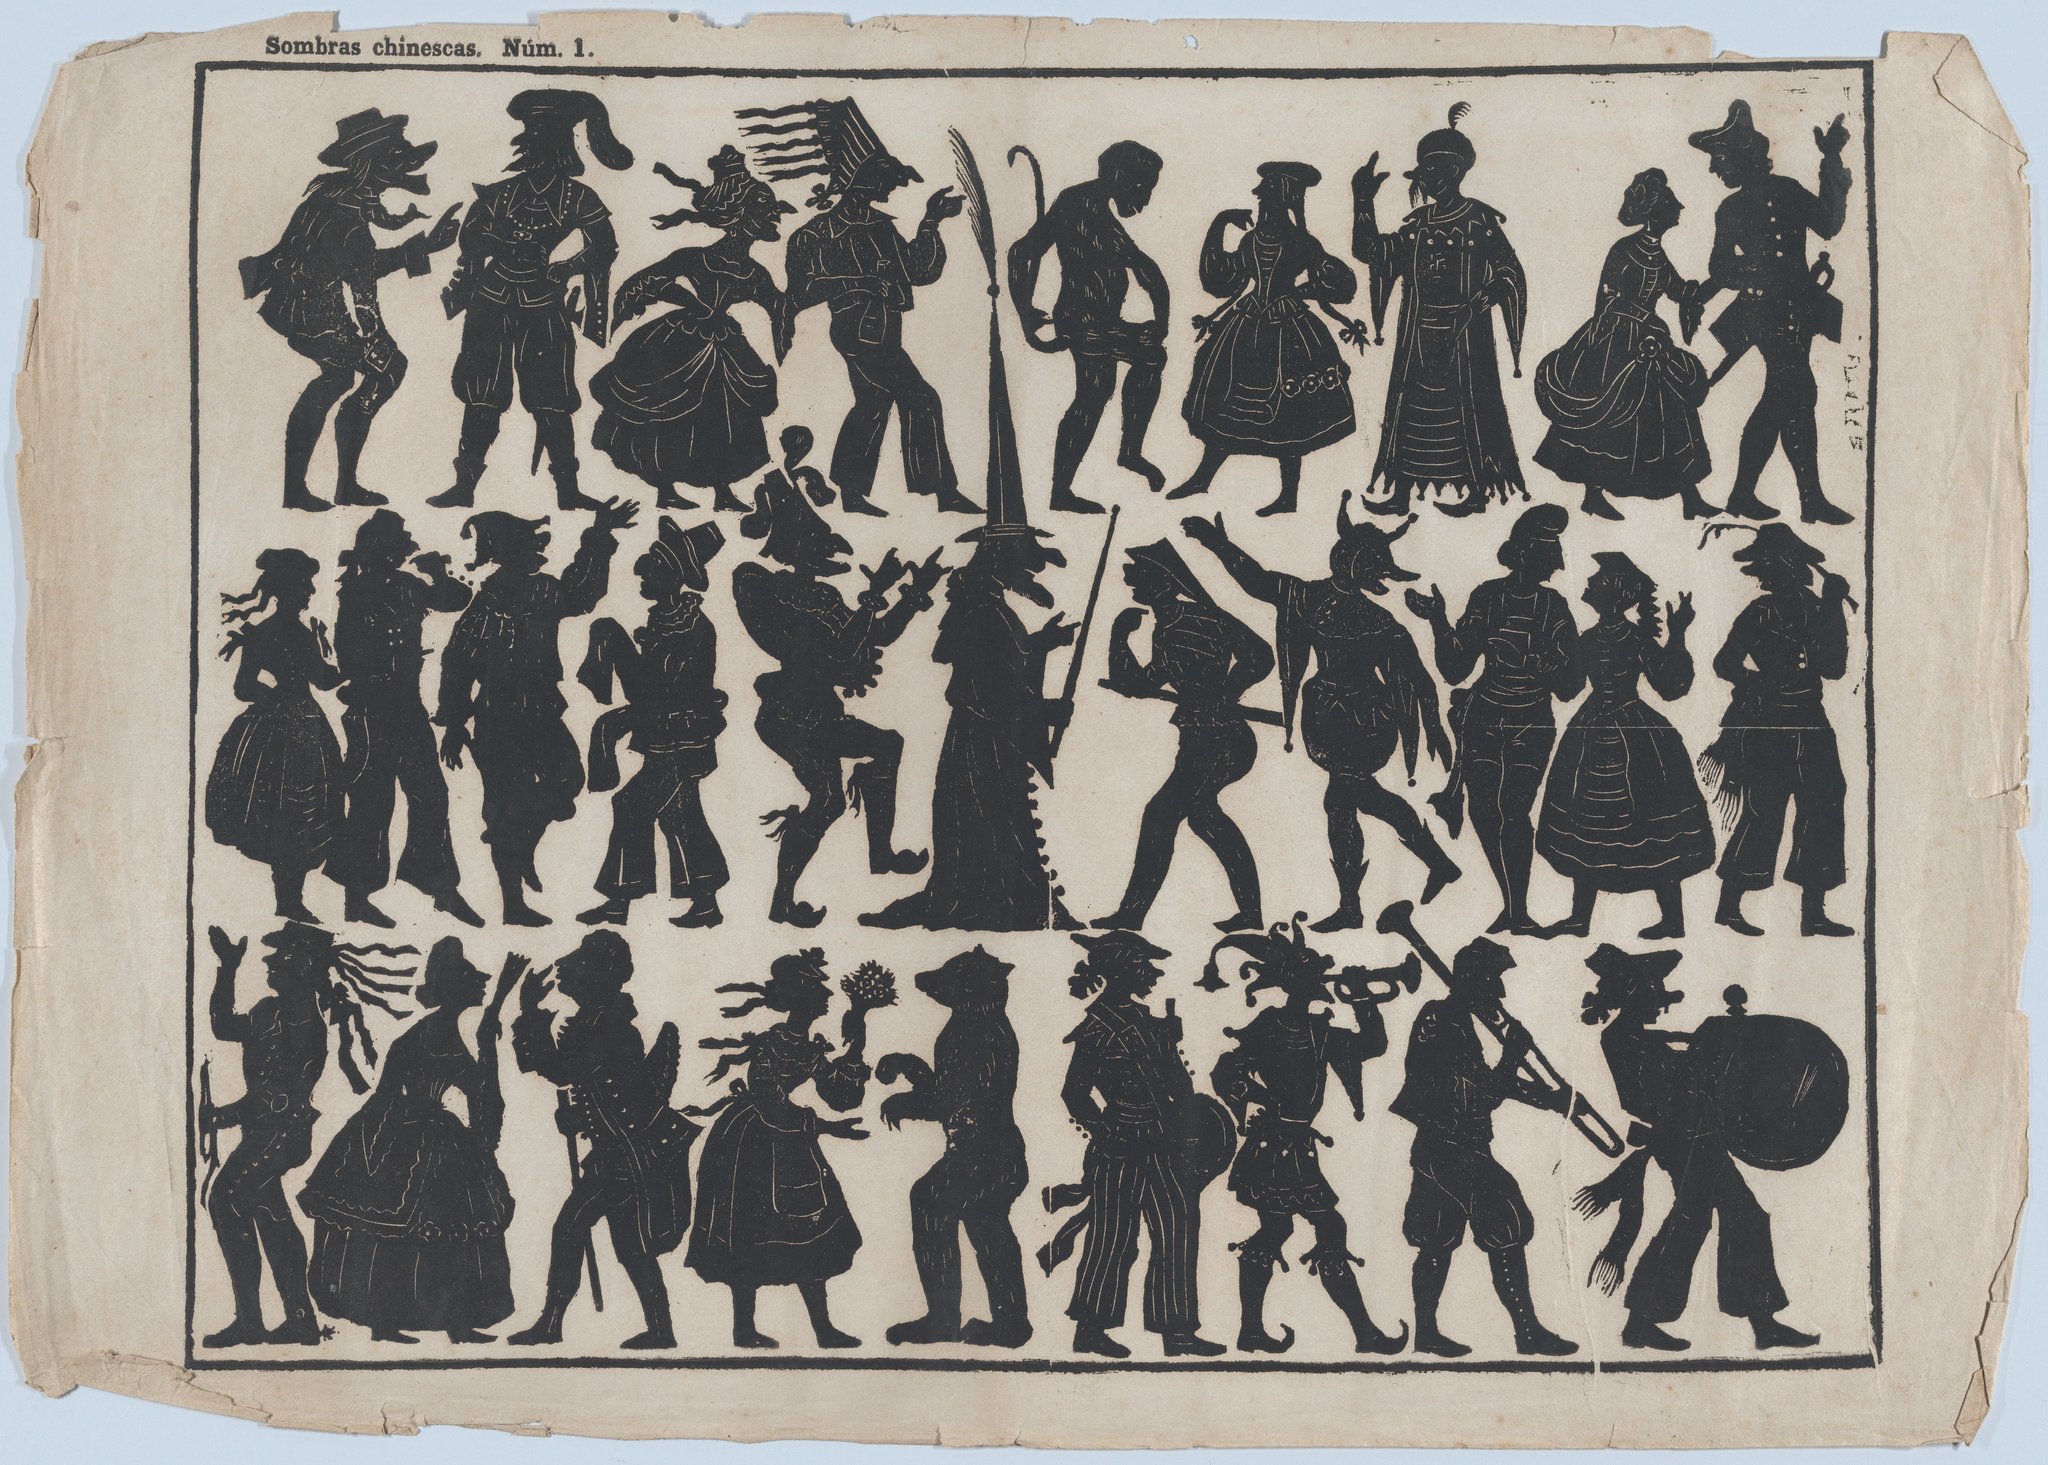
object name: print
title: Sheet 1 of figures for Chinese shadow puppets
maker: juan llorens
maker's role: publisher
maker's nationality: spanish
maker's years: 1800-1900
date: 1850-1870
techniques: woodcut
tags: musical instruments,men,women,puppets